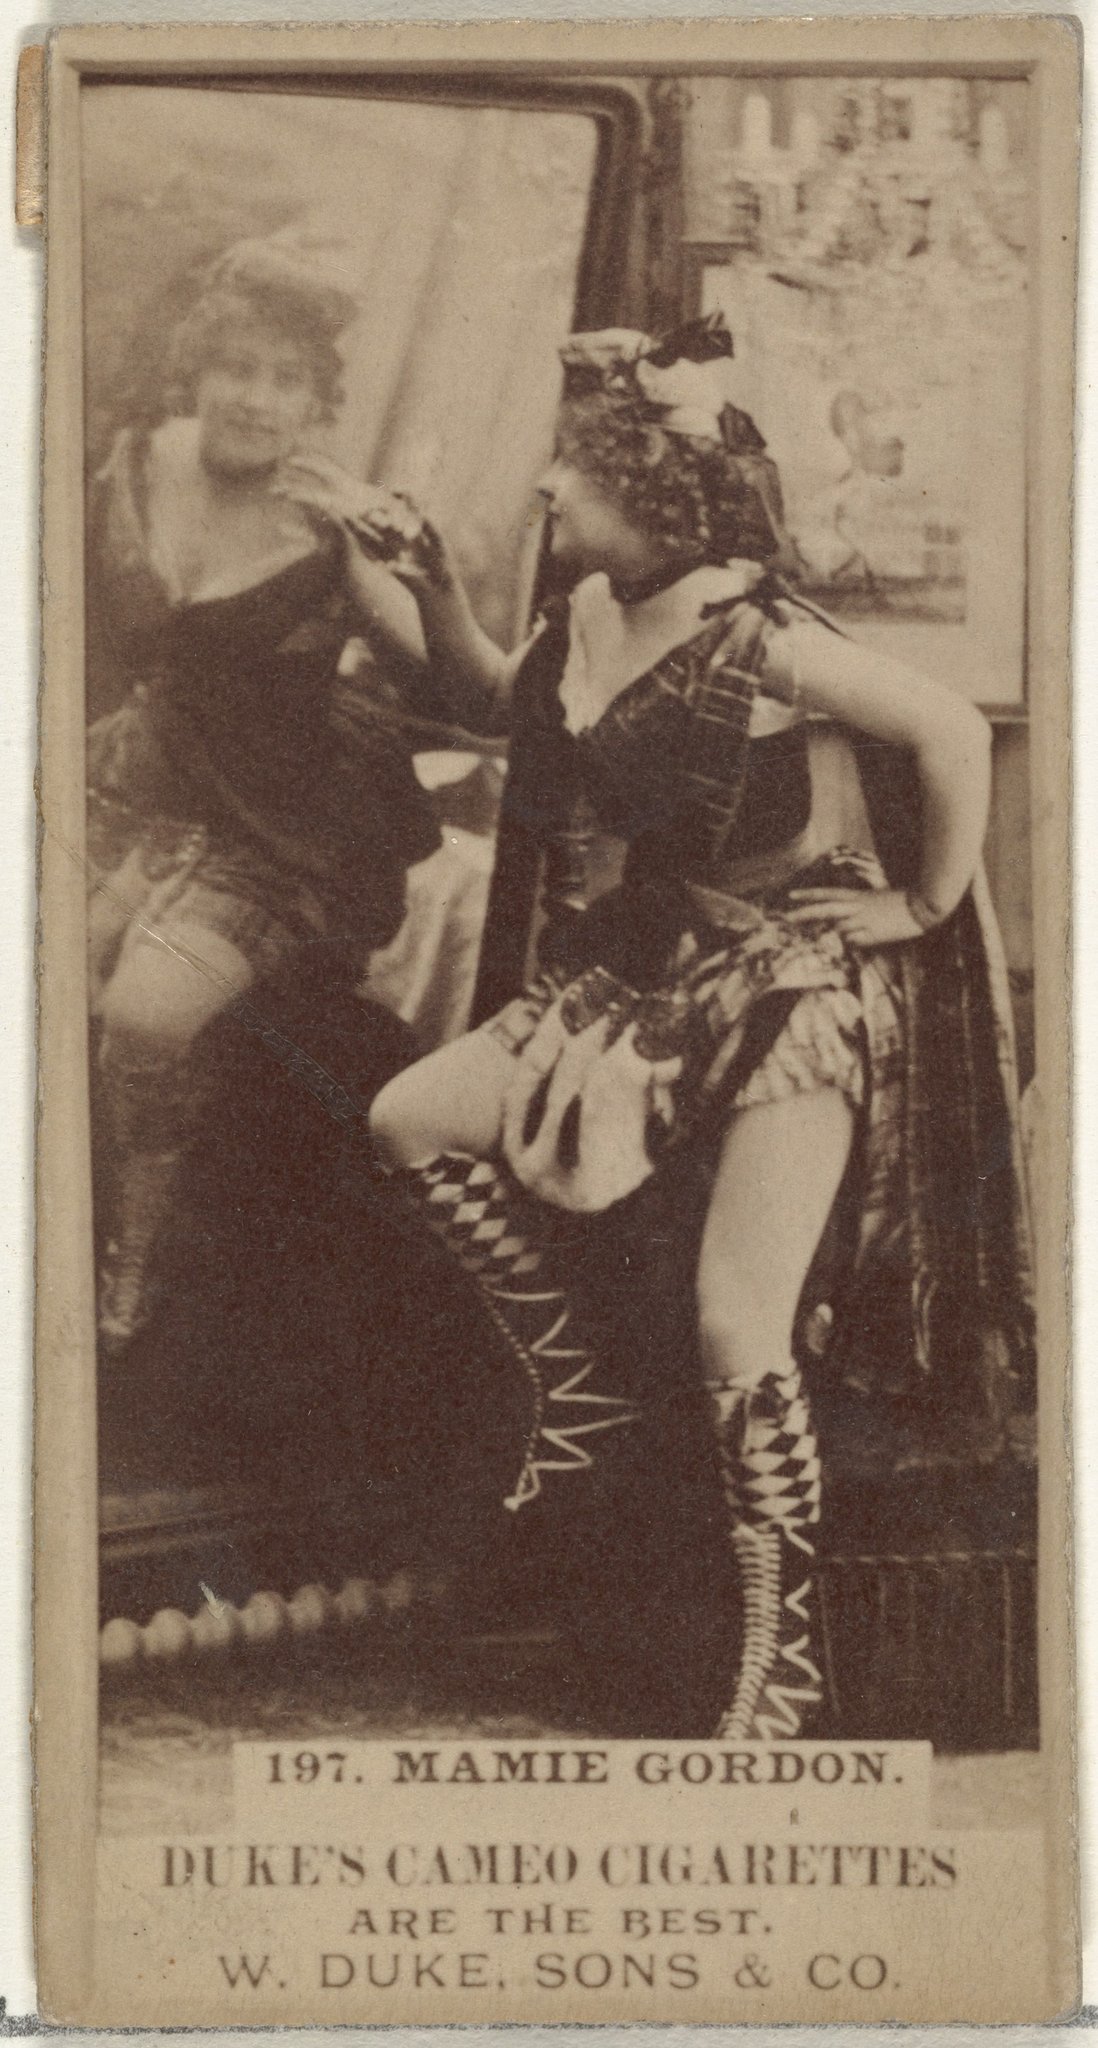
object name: photograph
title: Card Number 197, Mamie Gordon, from the Actors and Actresses series (N145-5) issued by Duke Sons & Co. to promote Cameo Cigarettes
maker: w. duke, sons & co.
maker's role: publisher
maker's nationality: american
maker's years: 1870-1920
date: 1880-1889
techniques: albumen silver print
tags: women,actresses,mirrors